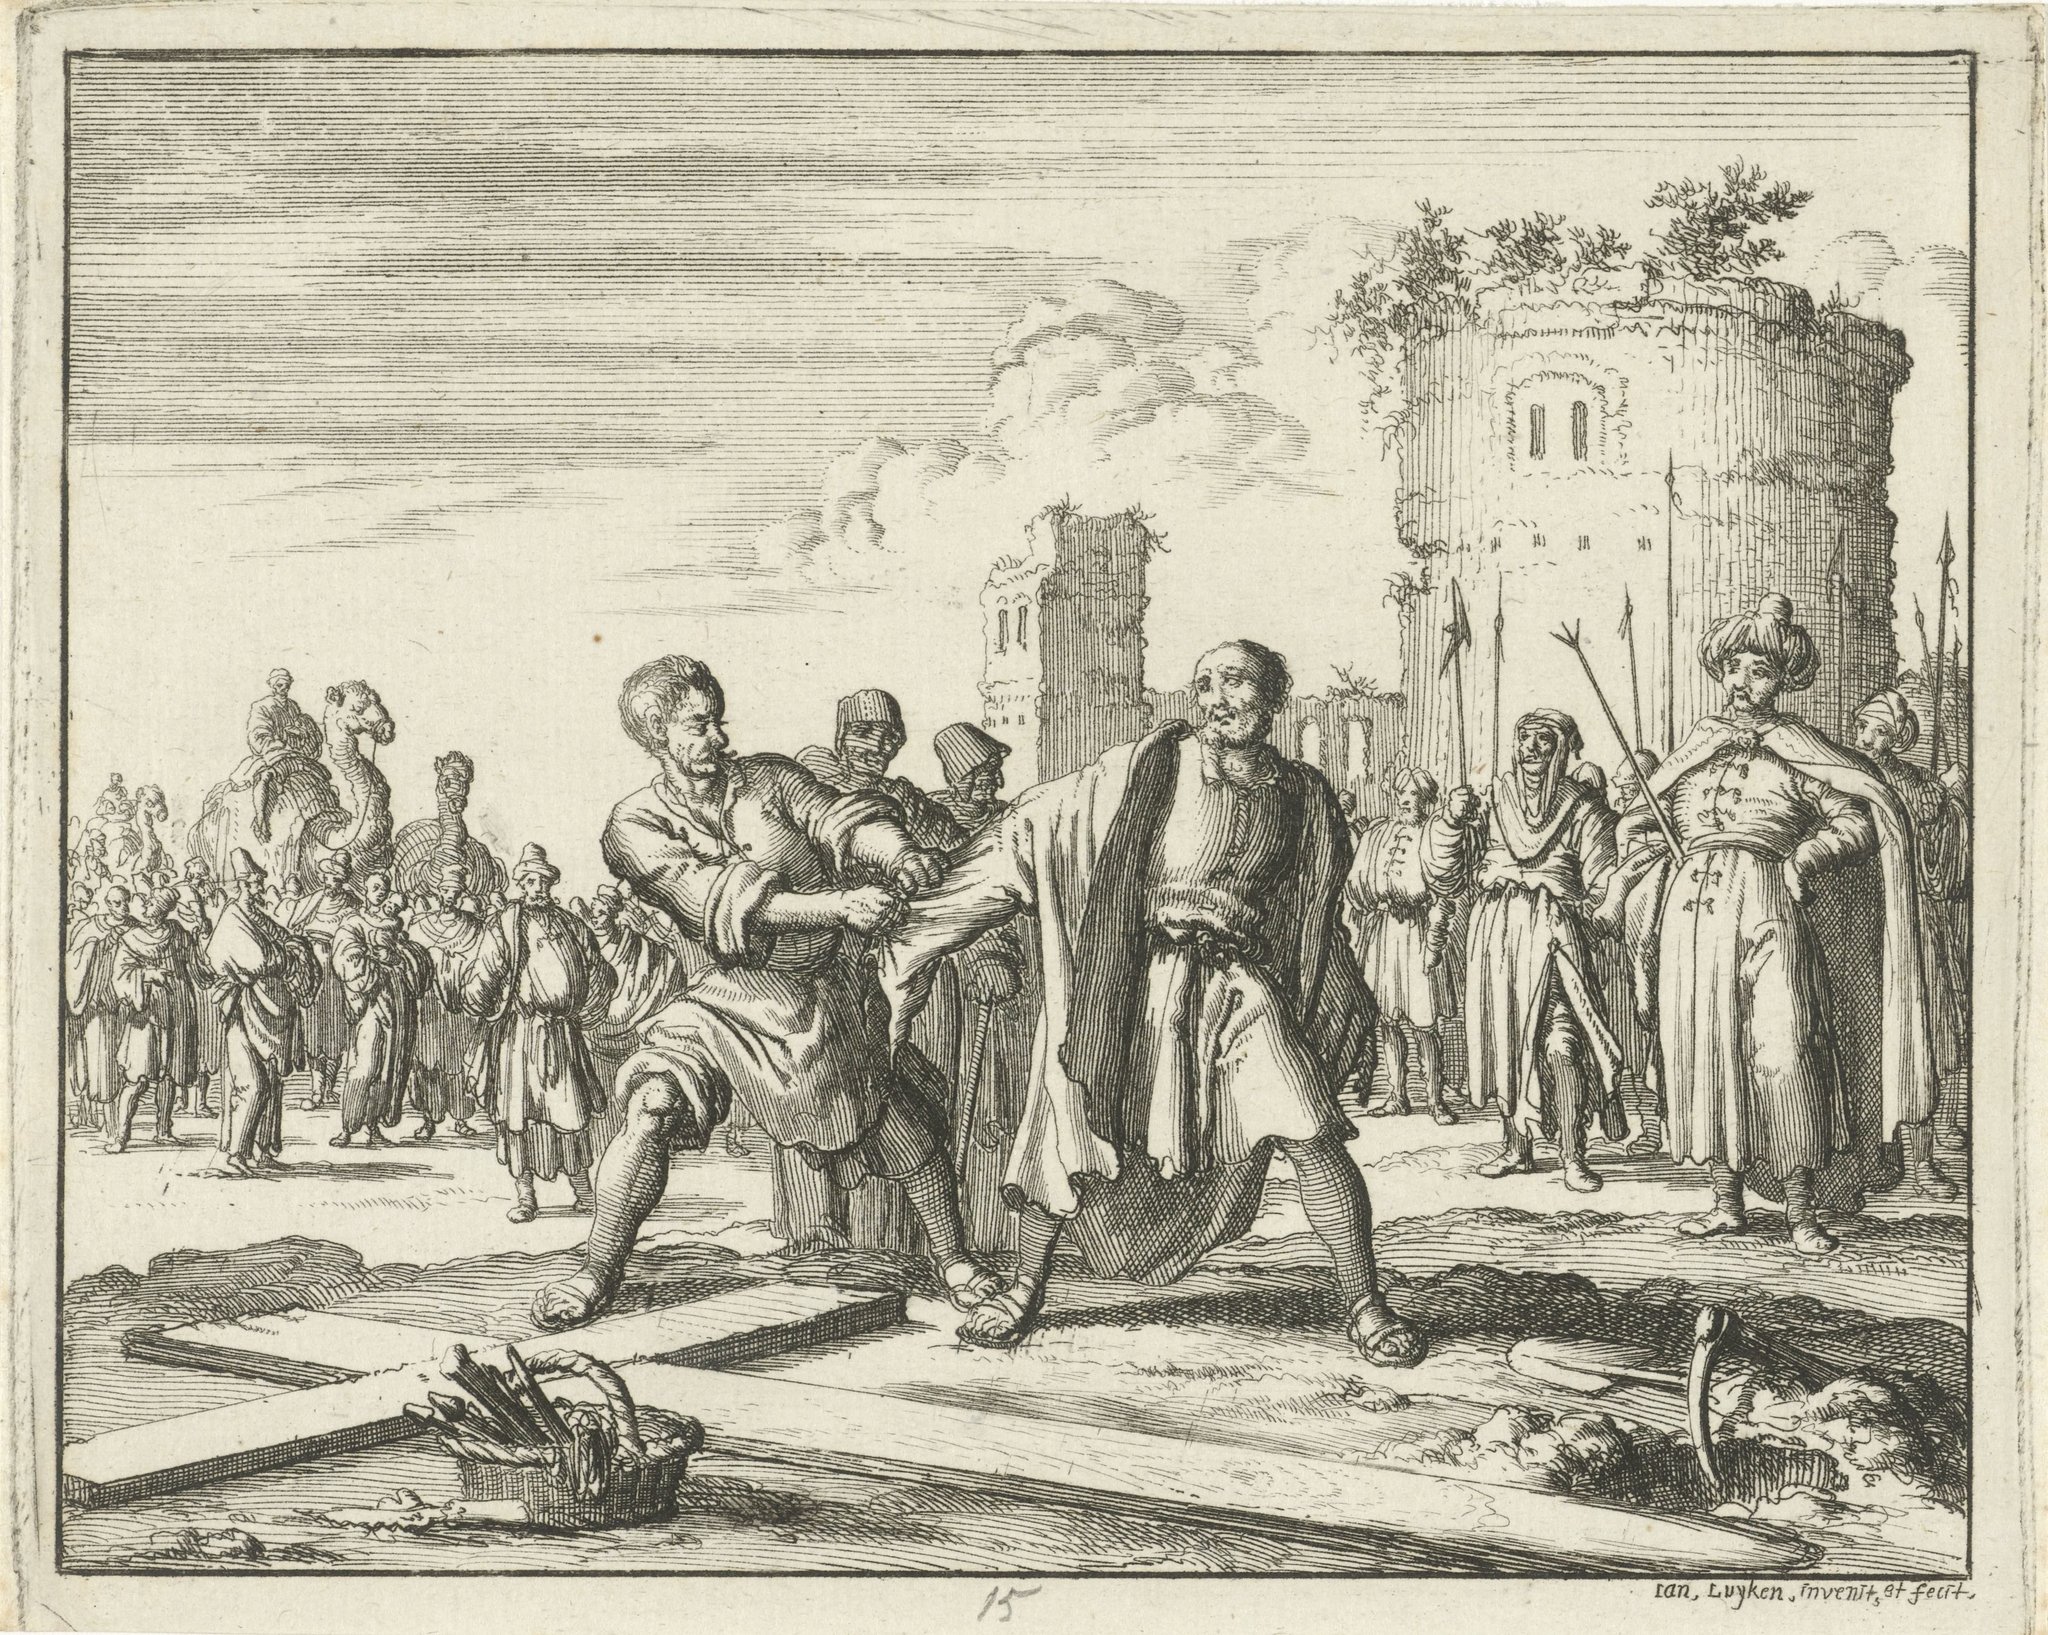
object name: book illustration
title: Simon Zelotes van zijn kleren ontdaan voor de kruisiging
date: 1685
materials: paper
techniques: etching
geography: amsterdam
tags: simon zelotes is crucified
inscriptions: collector's mark: Lugt 2228, number: ‘15’